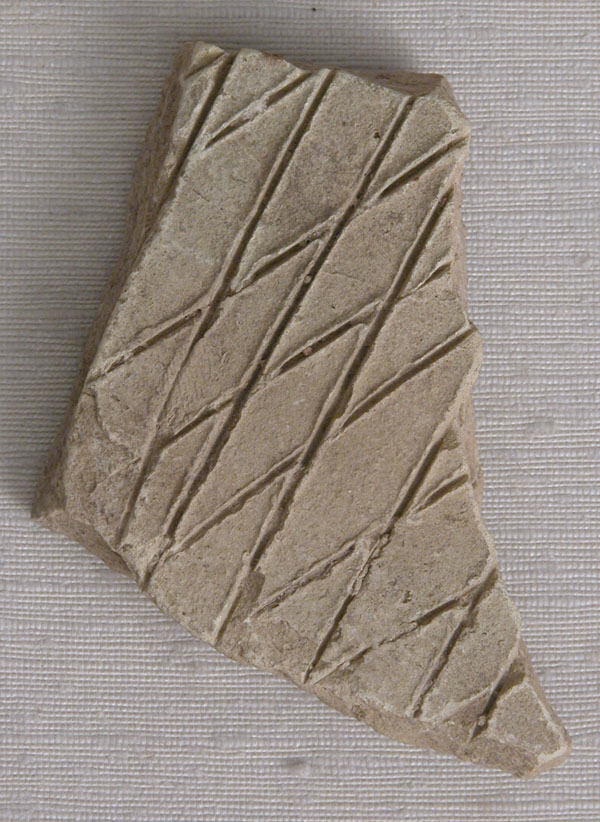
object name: fragment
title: Ceramic Fragment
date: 701-900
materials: earthenware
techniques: incising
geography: iraq